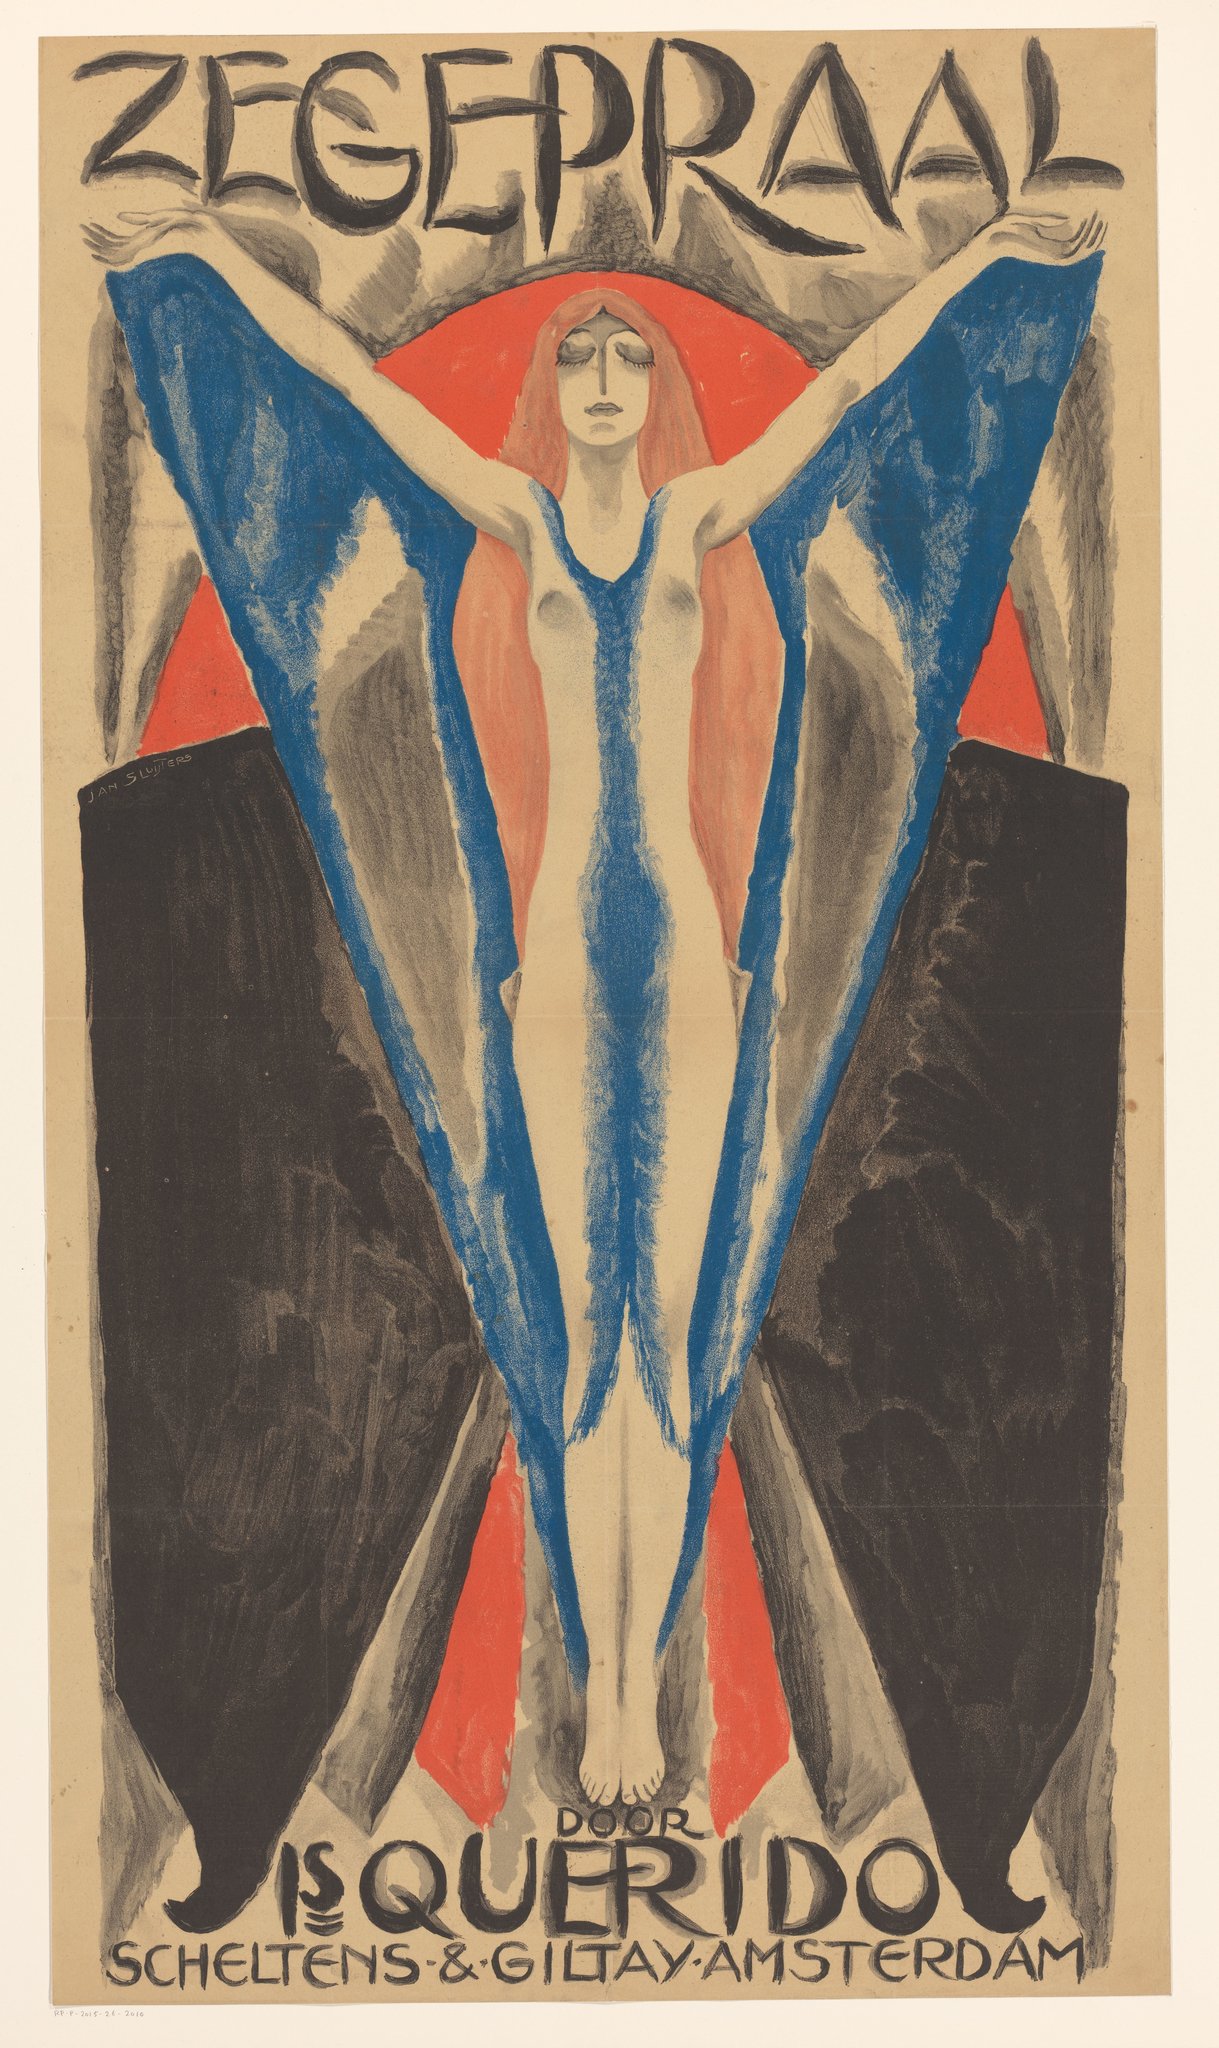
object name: poster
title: Affiche voor Zegepraal door Israël Querido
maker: jan sluijters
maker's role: draughtsman, print maker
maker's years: 1881-1957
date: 1923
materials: paper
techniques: lithograph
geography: amsterdam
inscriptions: collector's mark: Lugt 4779, collector's mark: Lugt 2228, collector's mark: ‘Collectie M.C. Sigal’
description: Een vrouw die haar handen opheft naar de hemel.